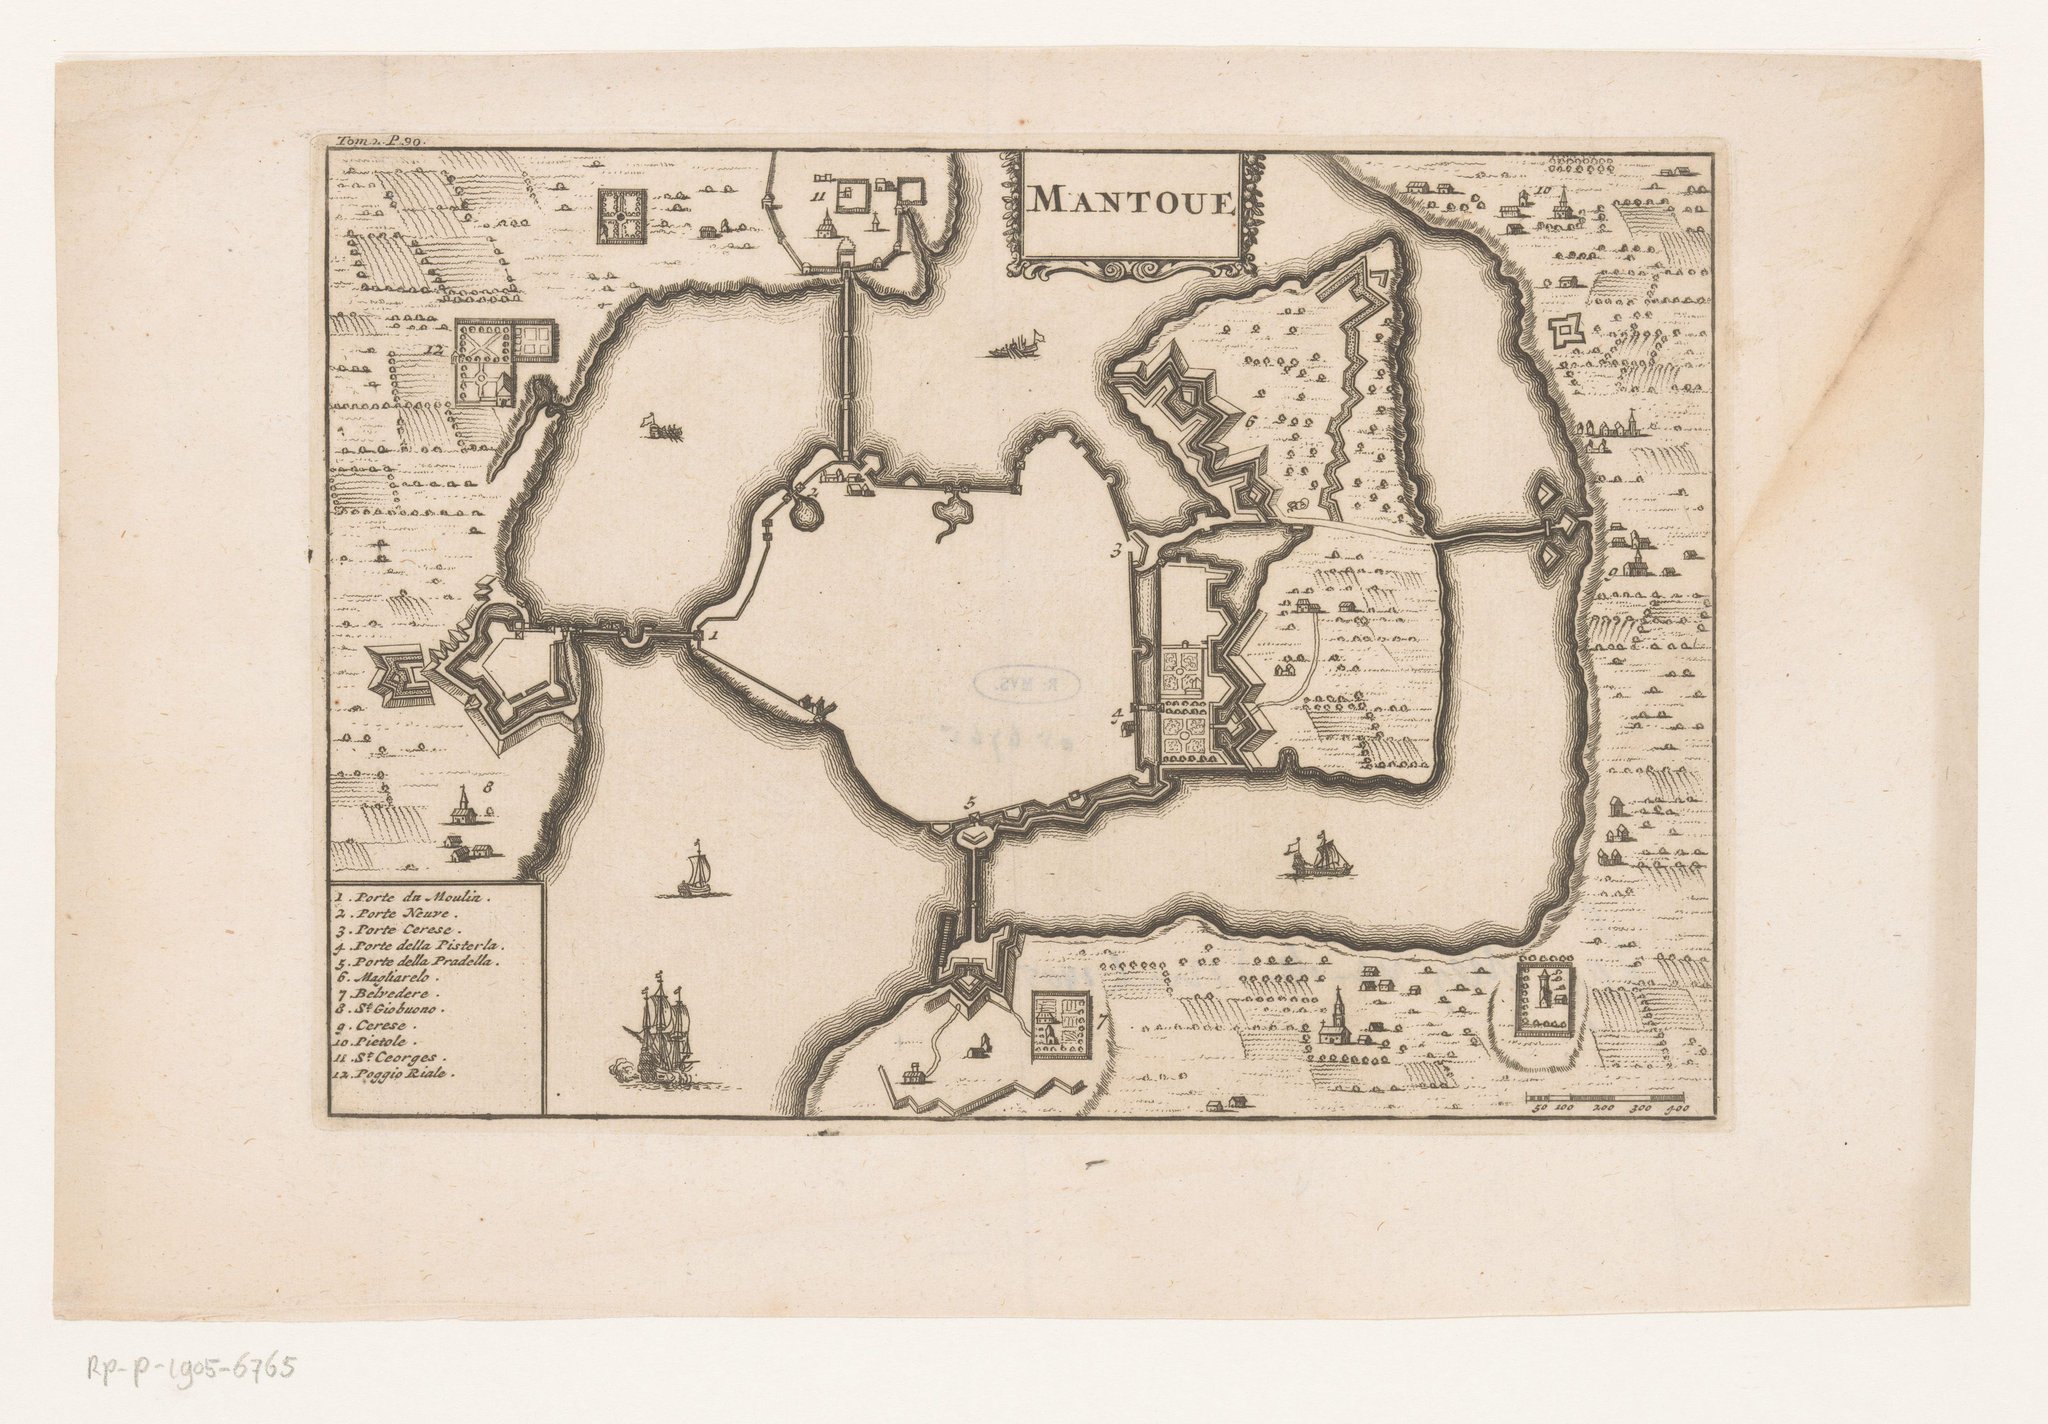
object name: area plan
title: Vestingplattegrond van Mantua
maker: Anonymous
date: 1700-1730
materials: paper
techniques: etching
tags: maps, atlases, fortified city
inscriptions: collector's mark: Lugt 2228